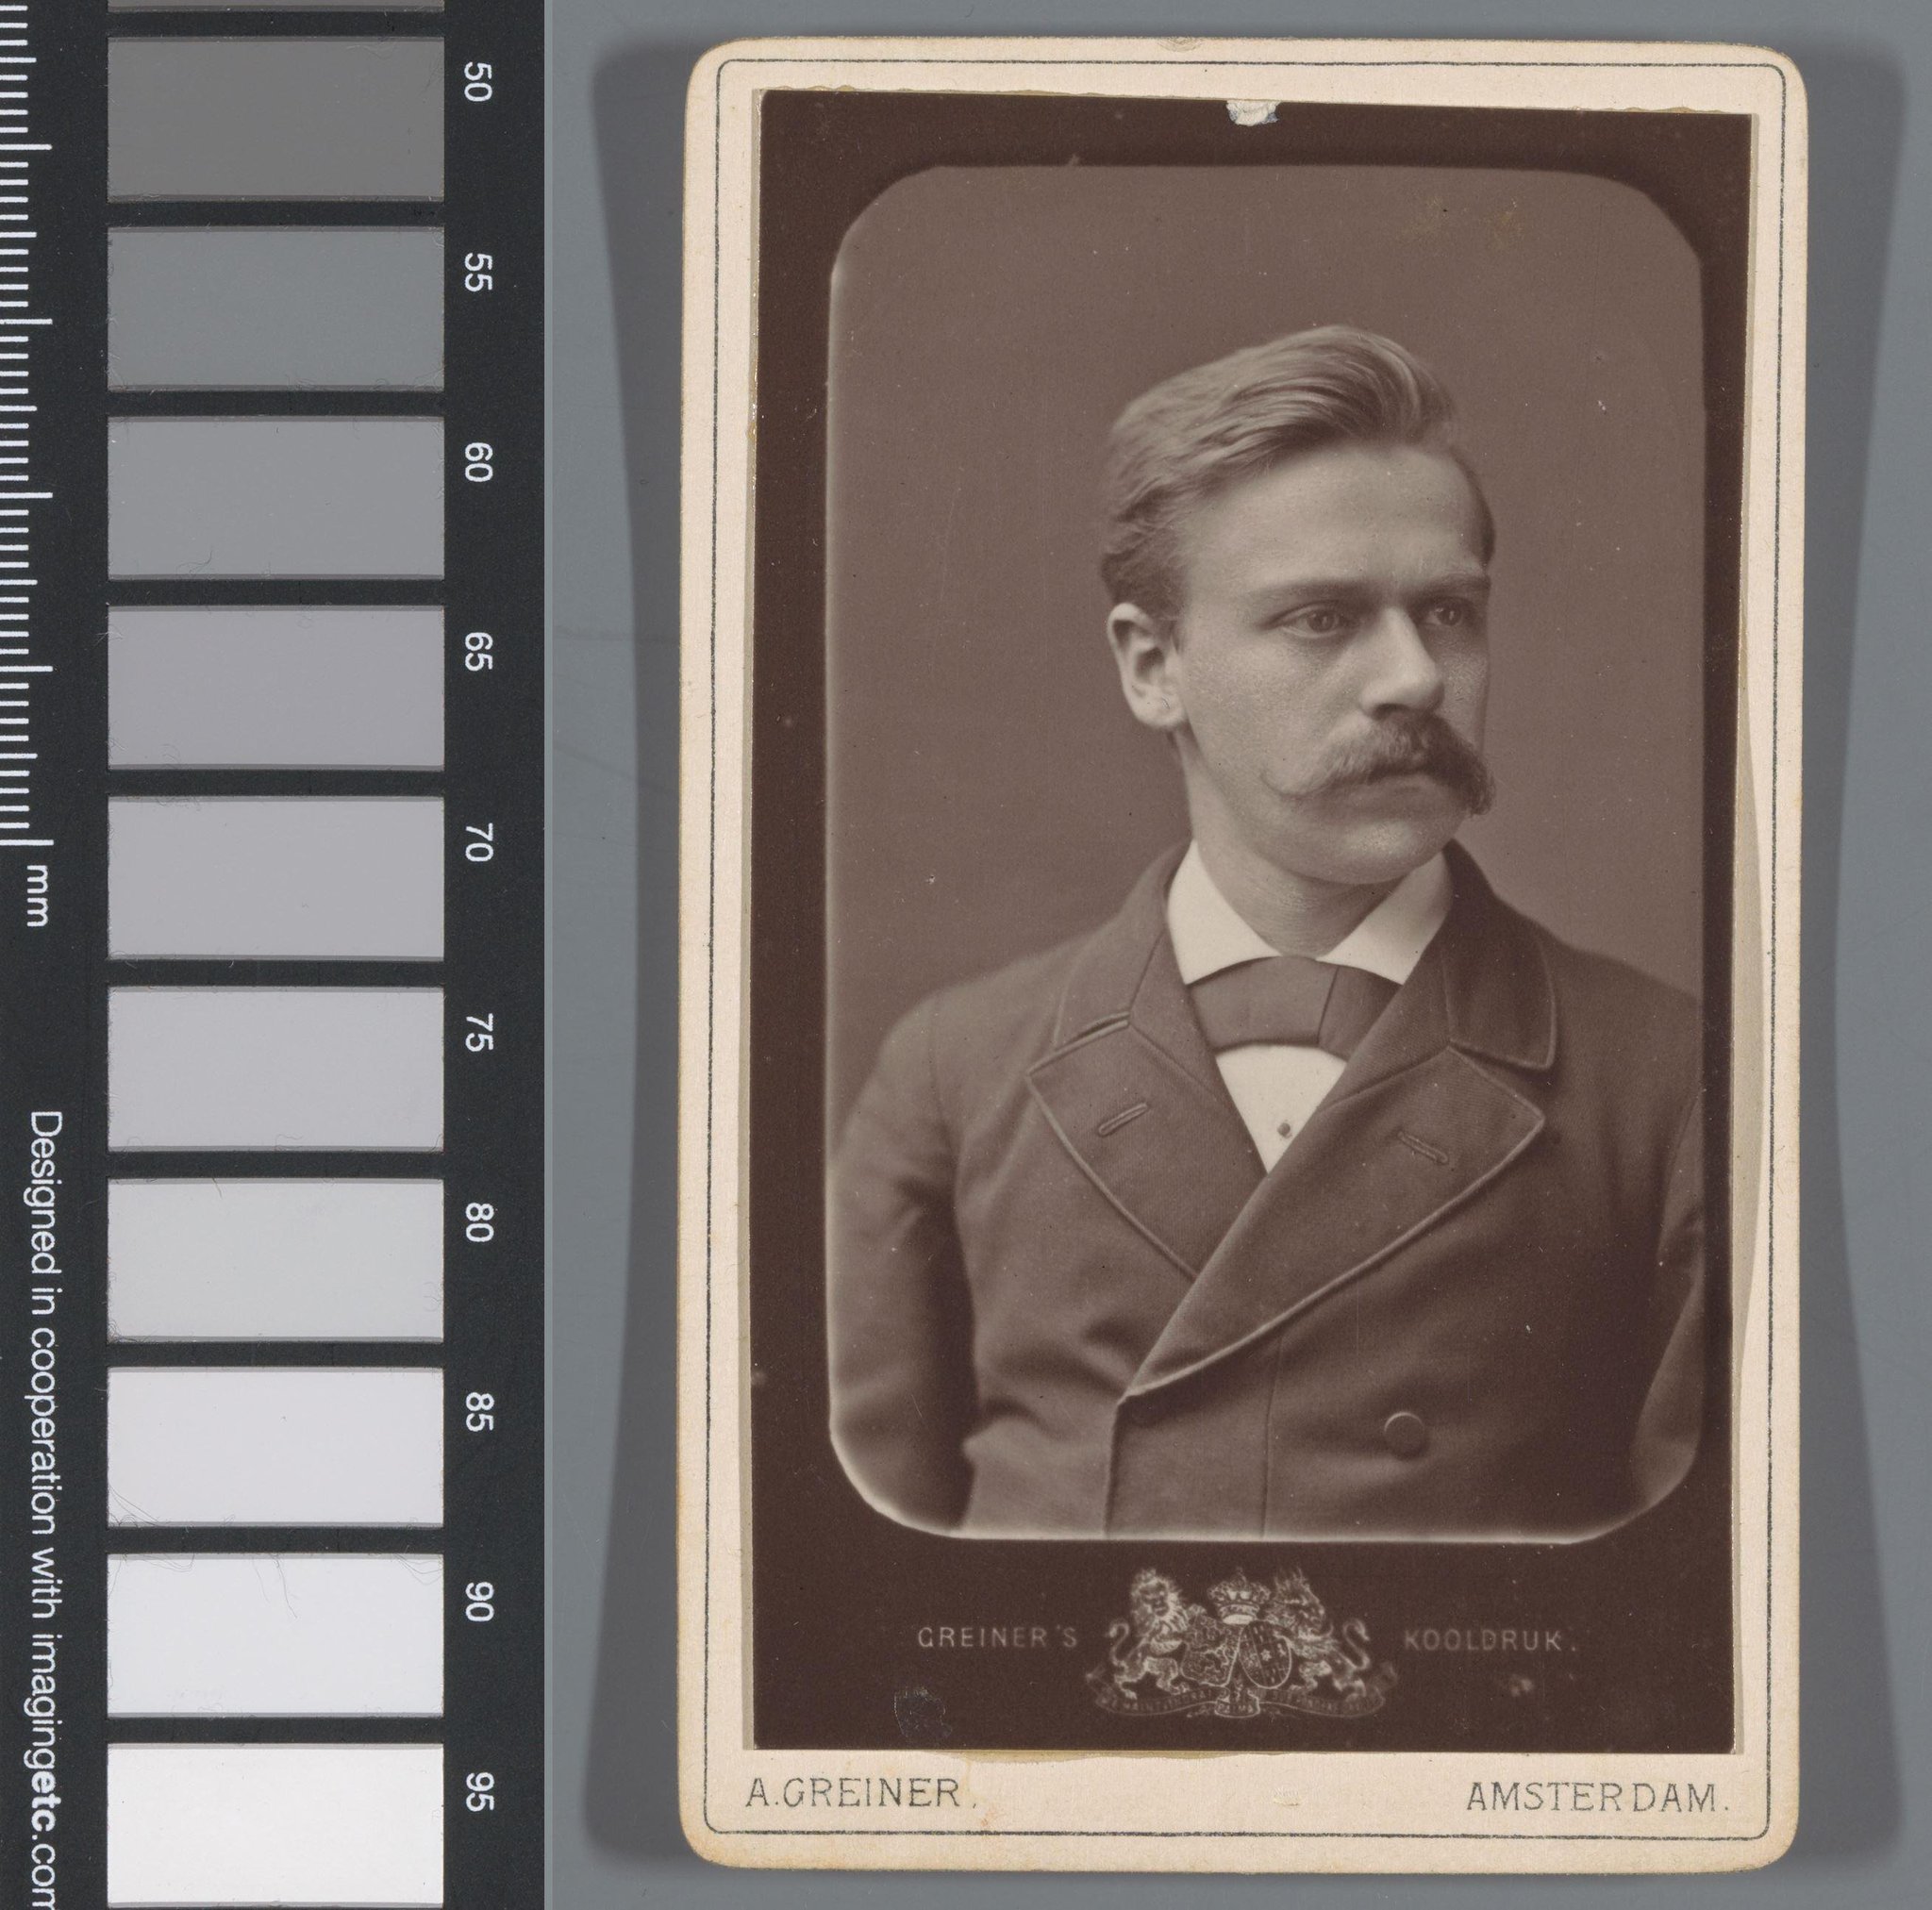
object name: carte de visite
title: Portret van een onbekende man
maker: albert greiner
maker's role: fotograaf, fotostudio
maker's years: 1833-1890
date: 1880-1887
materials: cardboard, celluloid, paper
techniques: albumen print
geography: amsterdam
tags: moustache, adult man, historical persons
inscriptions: inscription: ‘GREINER'S KOOLDRUK.’, inscription: ‘A. GREINER/ PHOTOGRAAF/ VAN H.H.M.M. DEN KONING EN/ DE KONINGIN DER NEDERLANDEN/ NIEUWENDIJK L. 89/ AMSTERDAM./ Specialiteit in Vergrootingen.’